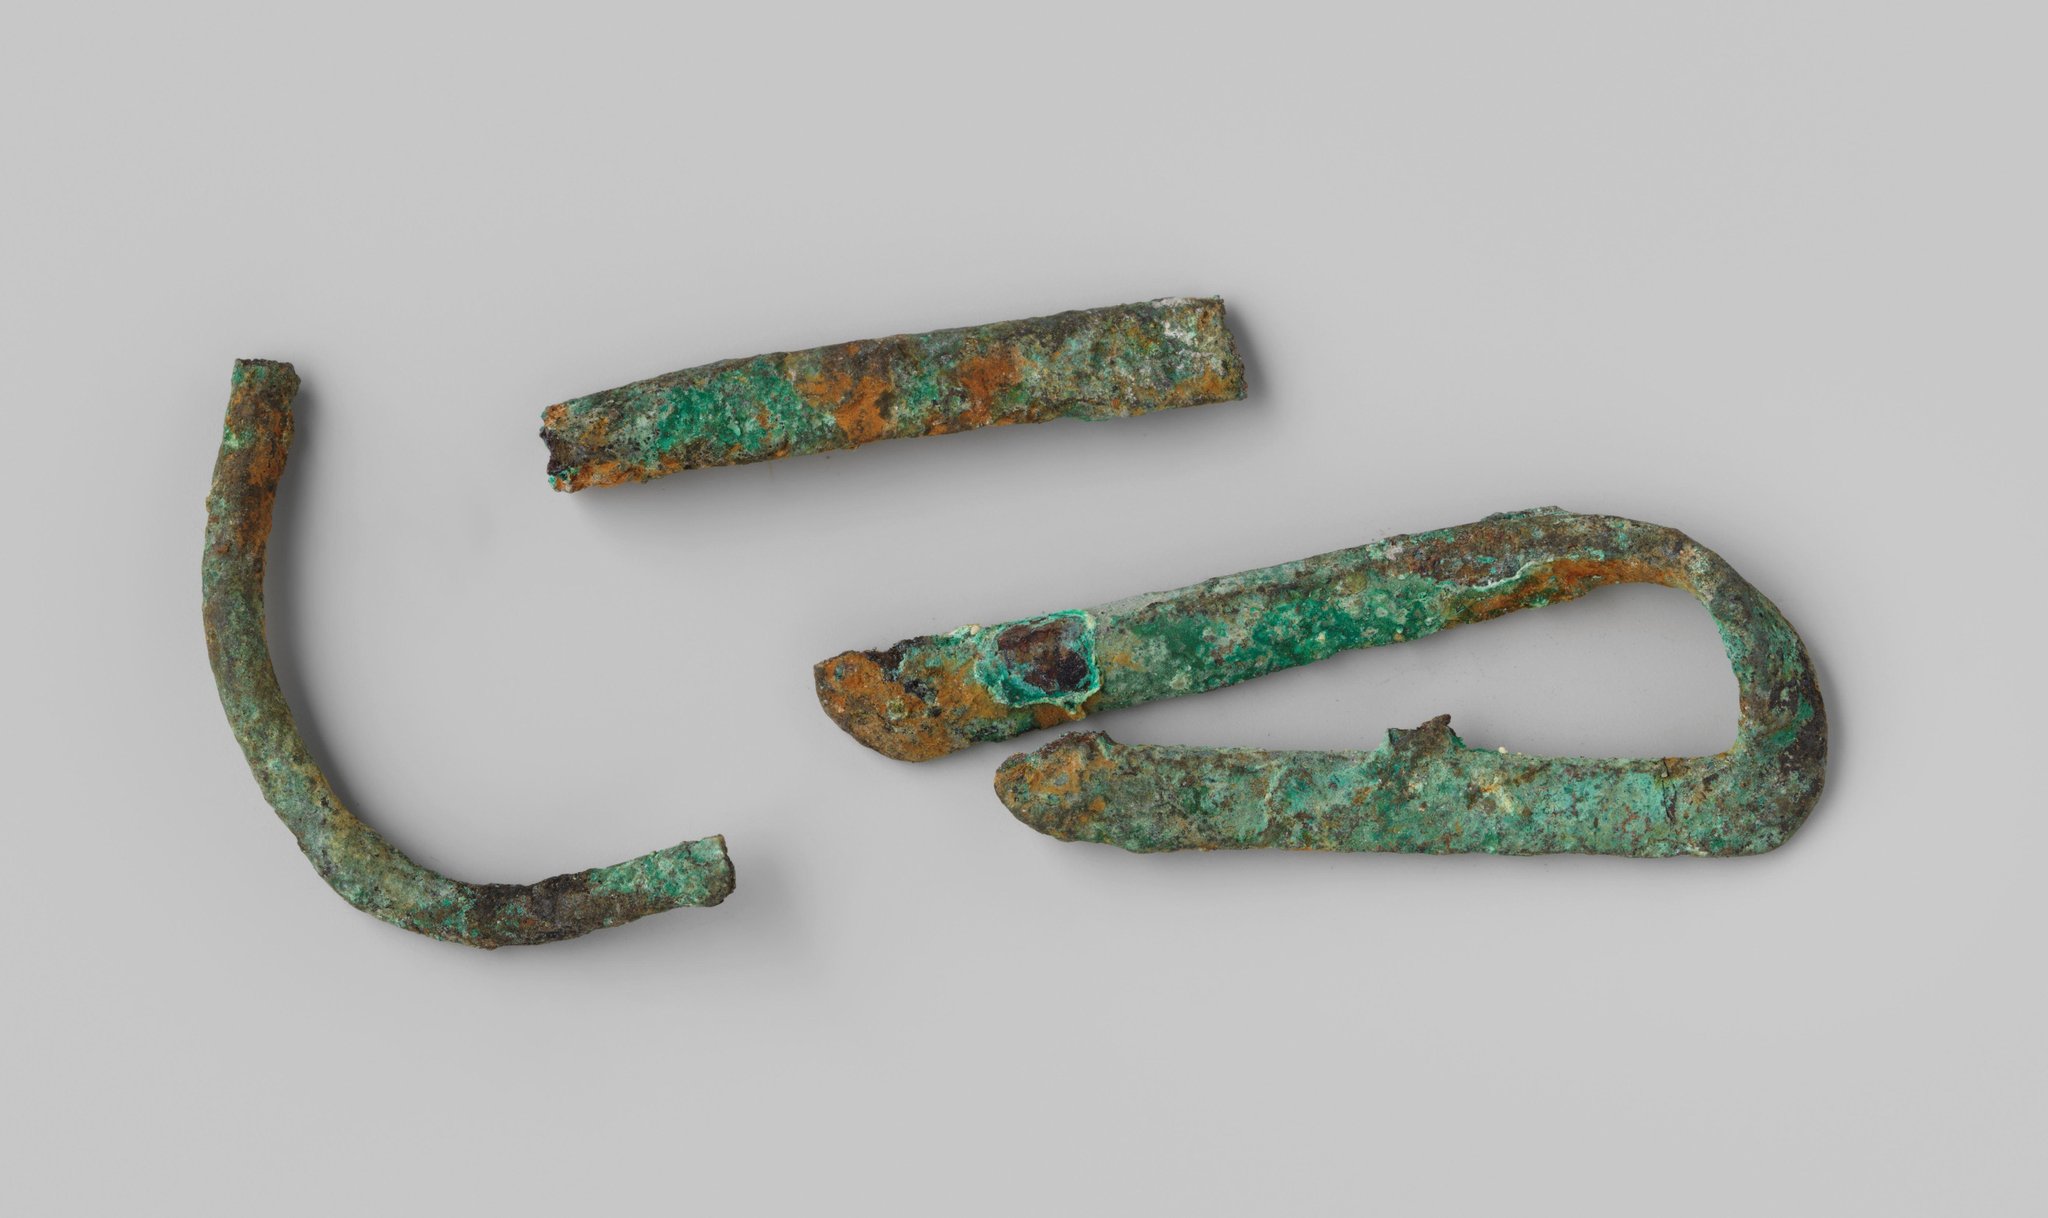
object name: belt buckle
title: Fragmenten riemgespen uit het wrak van de Oost-Indiëvaarder Hollandia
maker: Anonymous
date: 1700-1743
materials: copper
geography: netherlands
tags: verenigde oostindische compagnie, hollandia (schip), annet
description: Belt buckle, rectangular, fragm of rings, id. NG 1980-27H2796.